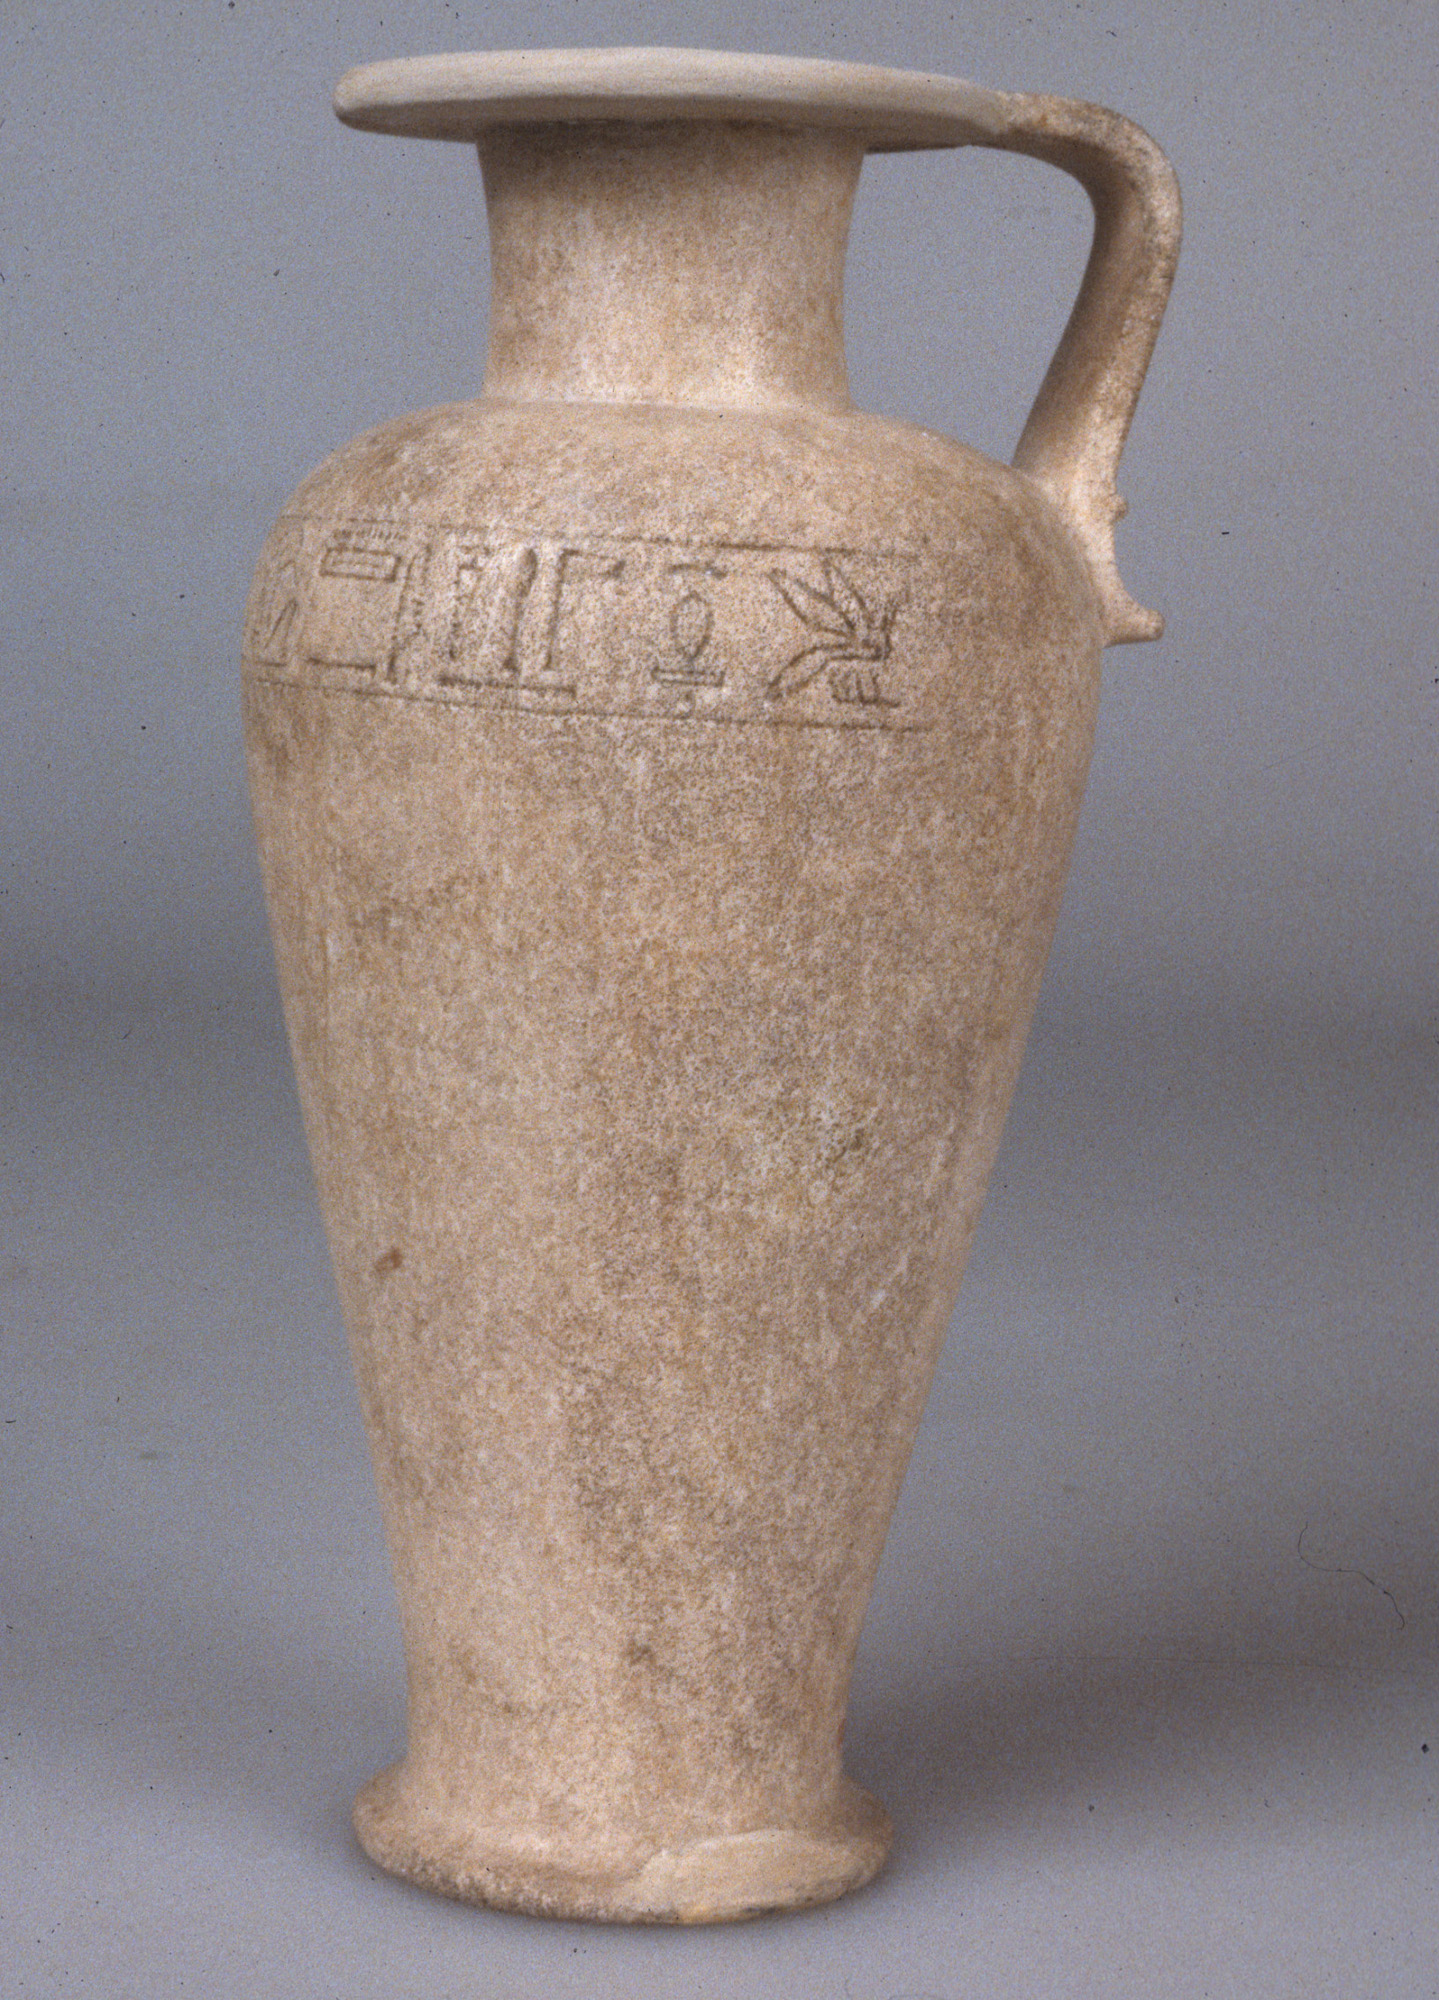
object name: jug, menkheperreseneb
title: Jug of the Treasurer and High Priest of Amun, Menkheperreseneb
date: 1479-1425 BCE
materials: limestone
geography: egypt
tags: amun